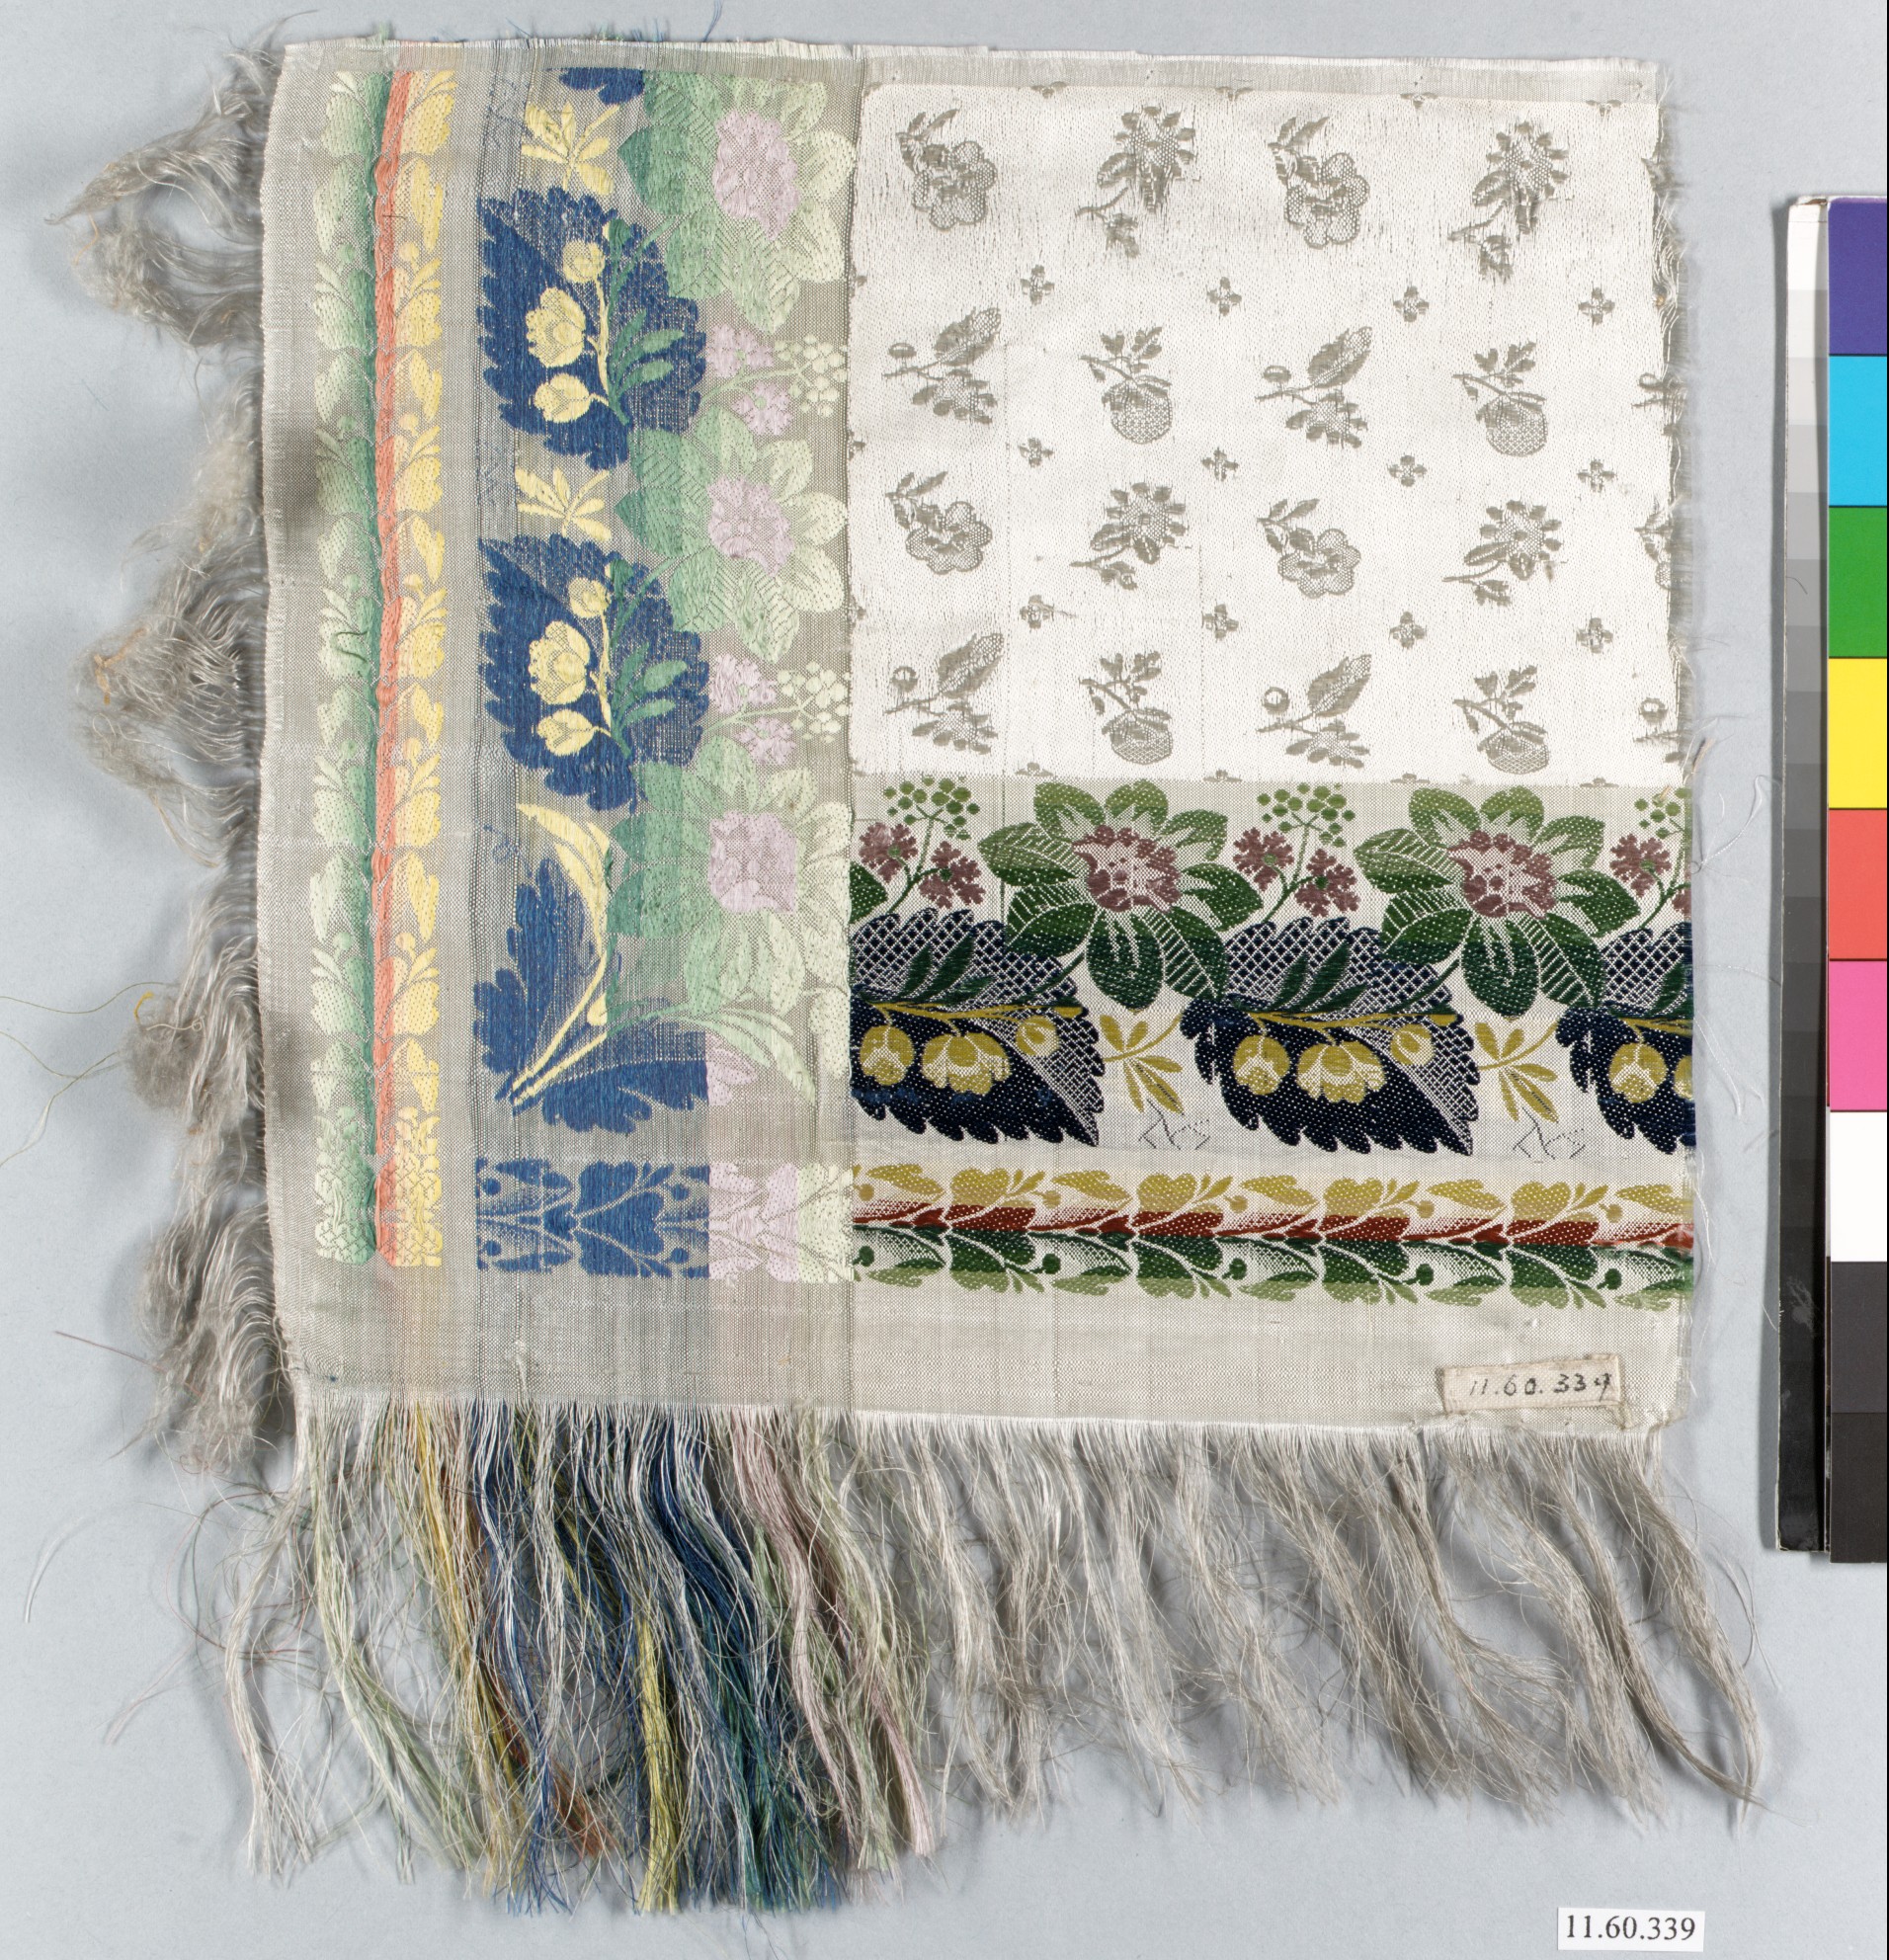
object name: fragment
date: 1801-1900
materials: silk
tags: flowers,leaves